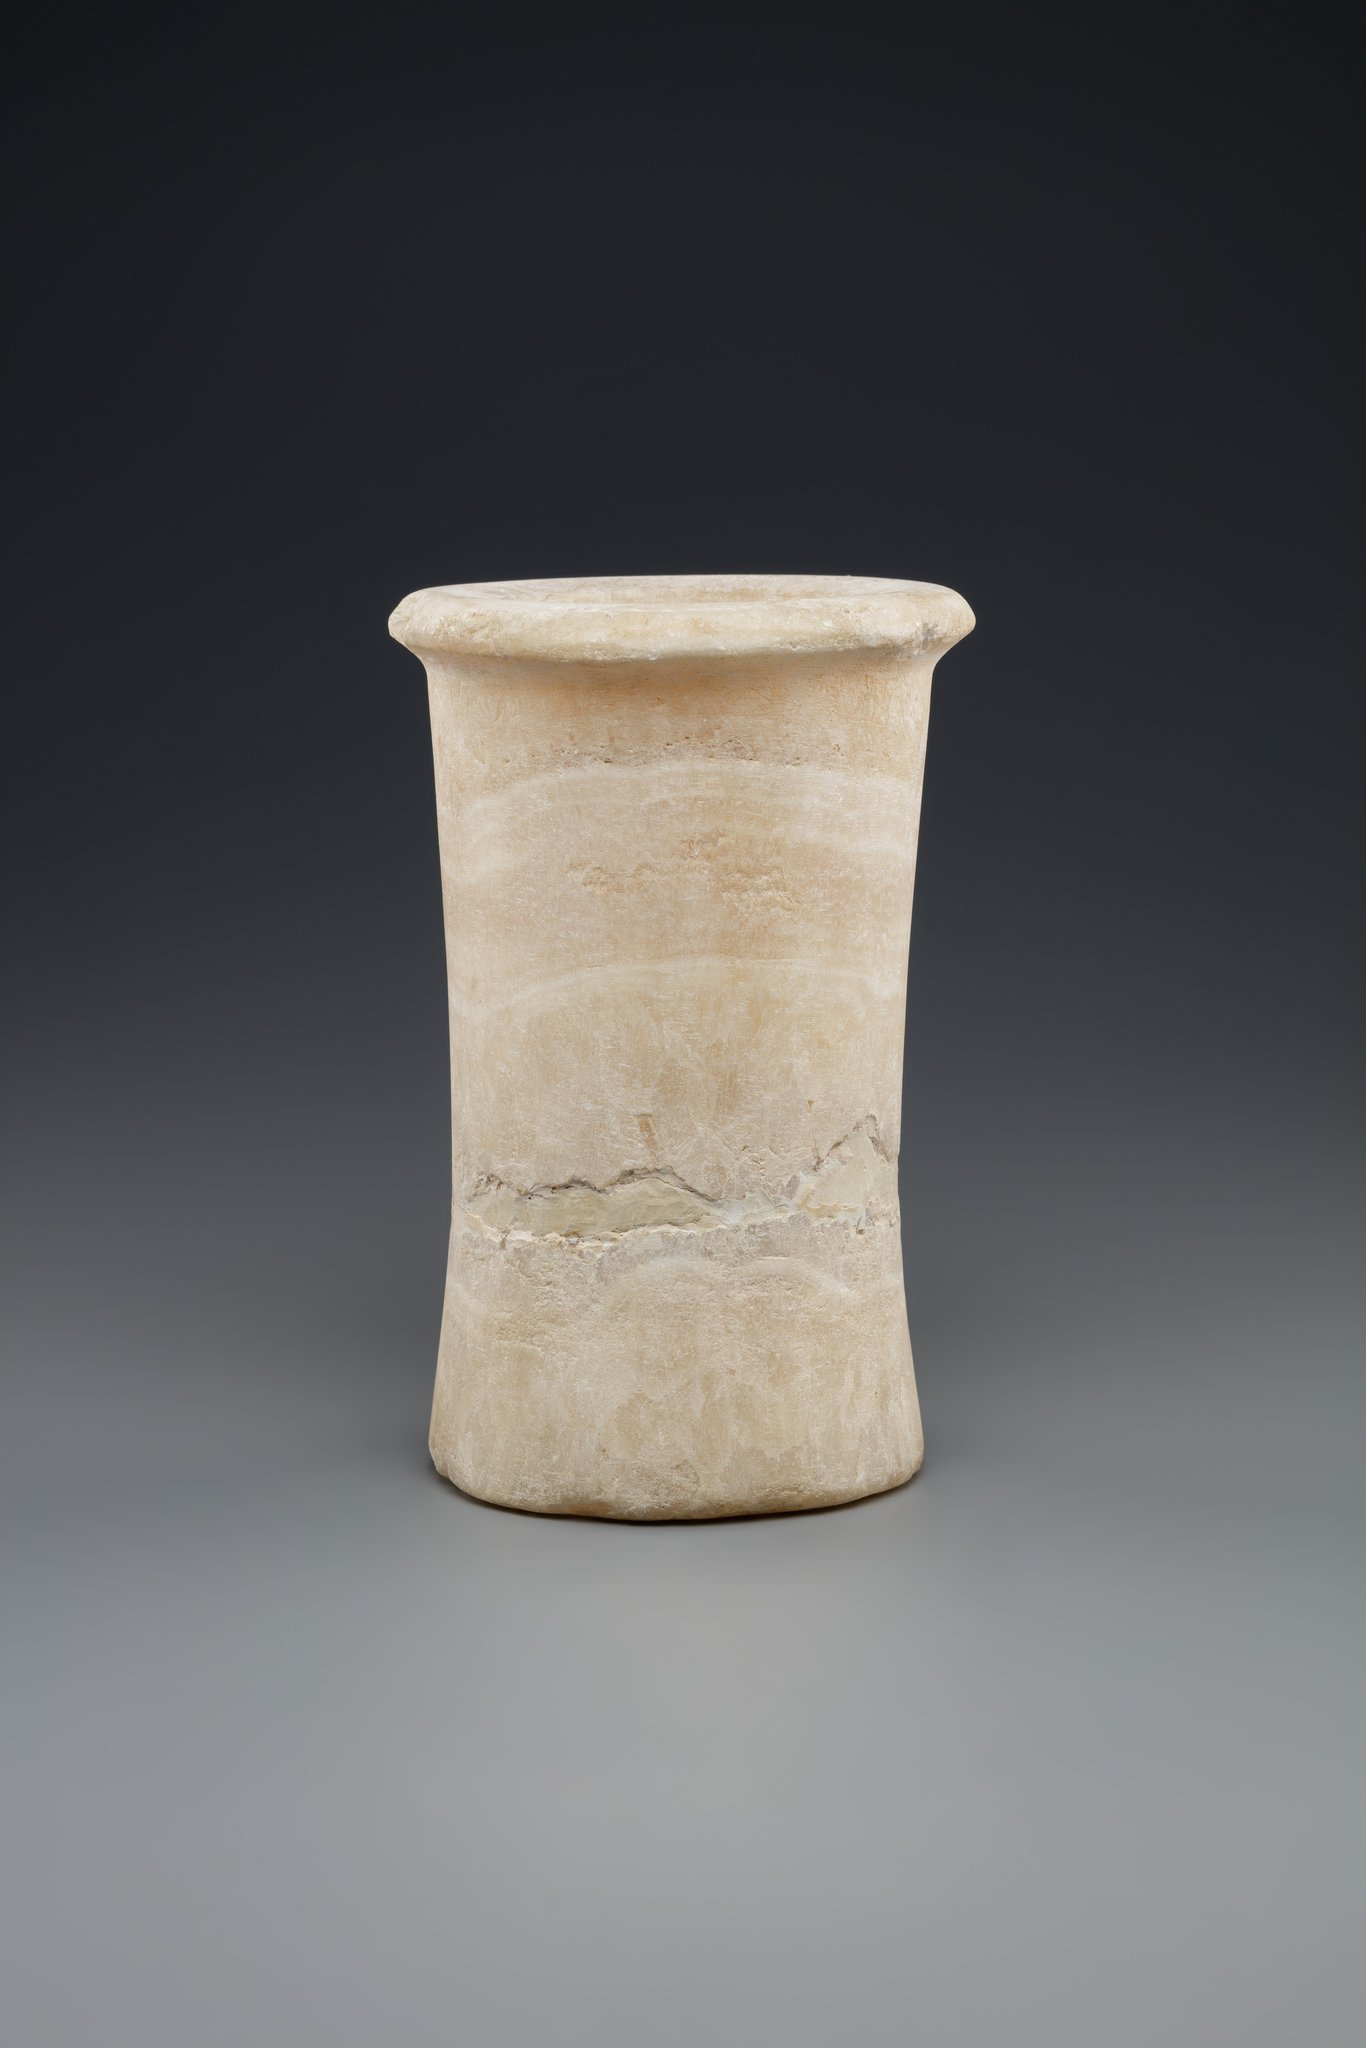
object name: jar, cylindrical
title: Cylinder jar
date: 3100-2649 BCE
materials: stone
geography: egypt